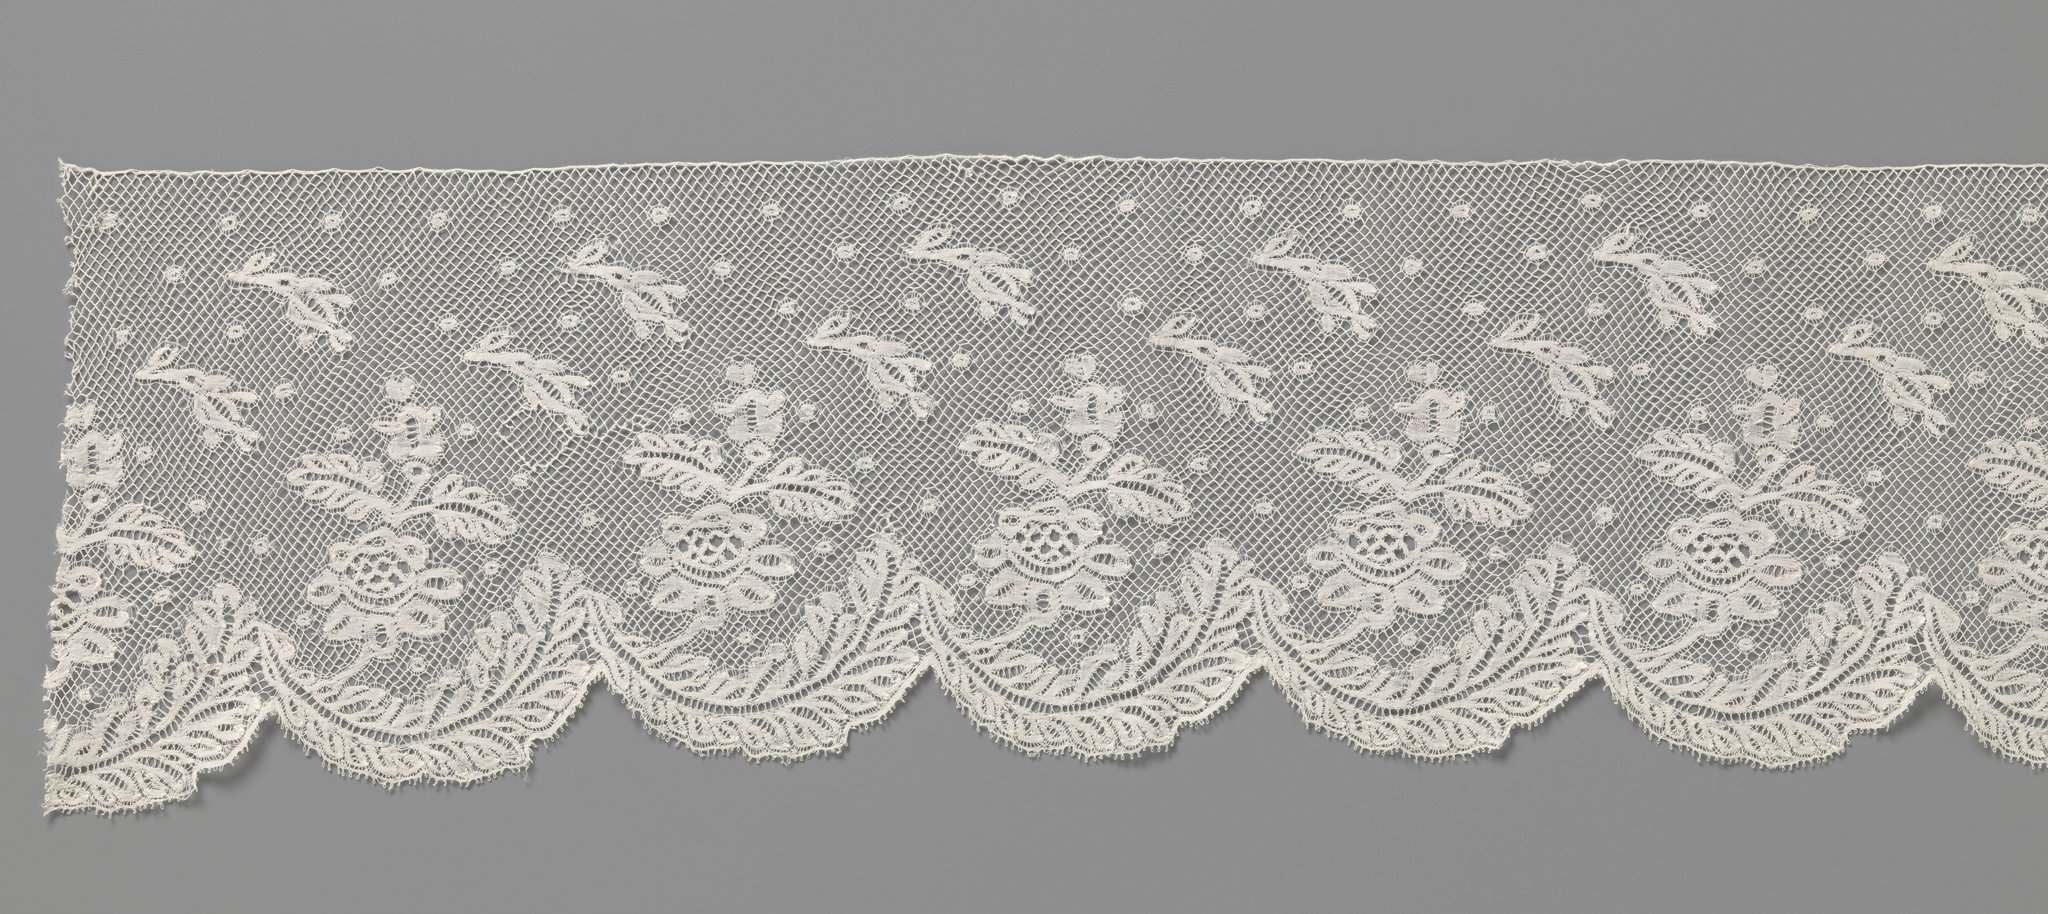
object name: strip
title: Strook kloskant met anemonen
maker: Anonymous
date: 1850-1874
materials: linen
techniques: lace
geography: sluis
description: Op een grof mazenfond (vierkante maas) staat een lopend patroon. In een open gedeelte staan twee rijen rozenknopjes tussen moesjes. In een meer gevuld gedeelte staat boven de gevederde bladeren die de halfcirkelvormige schulpen vormen een daaruit voortkomende tak met een anemoon, een dubbelblad en een knop. De strook bestaat uit vier aan elkaar genaaide delen en is in 1966 aan een strook genaaid met een vergelijkbaar, maar niet identiek patroon. Valenciennes-kant.